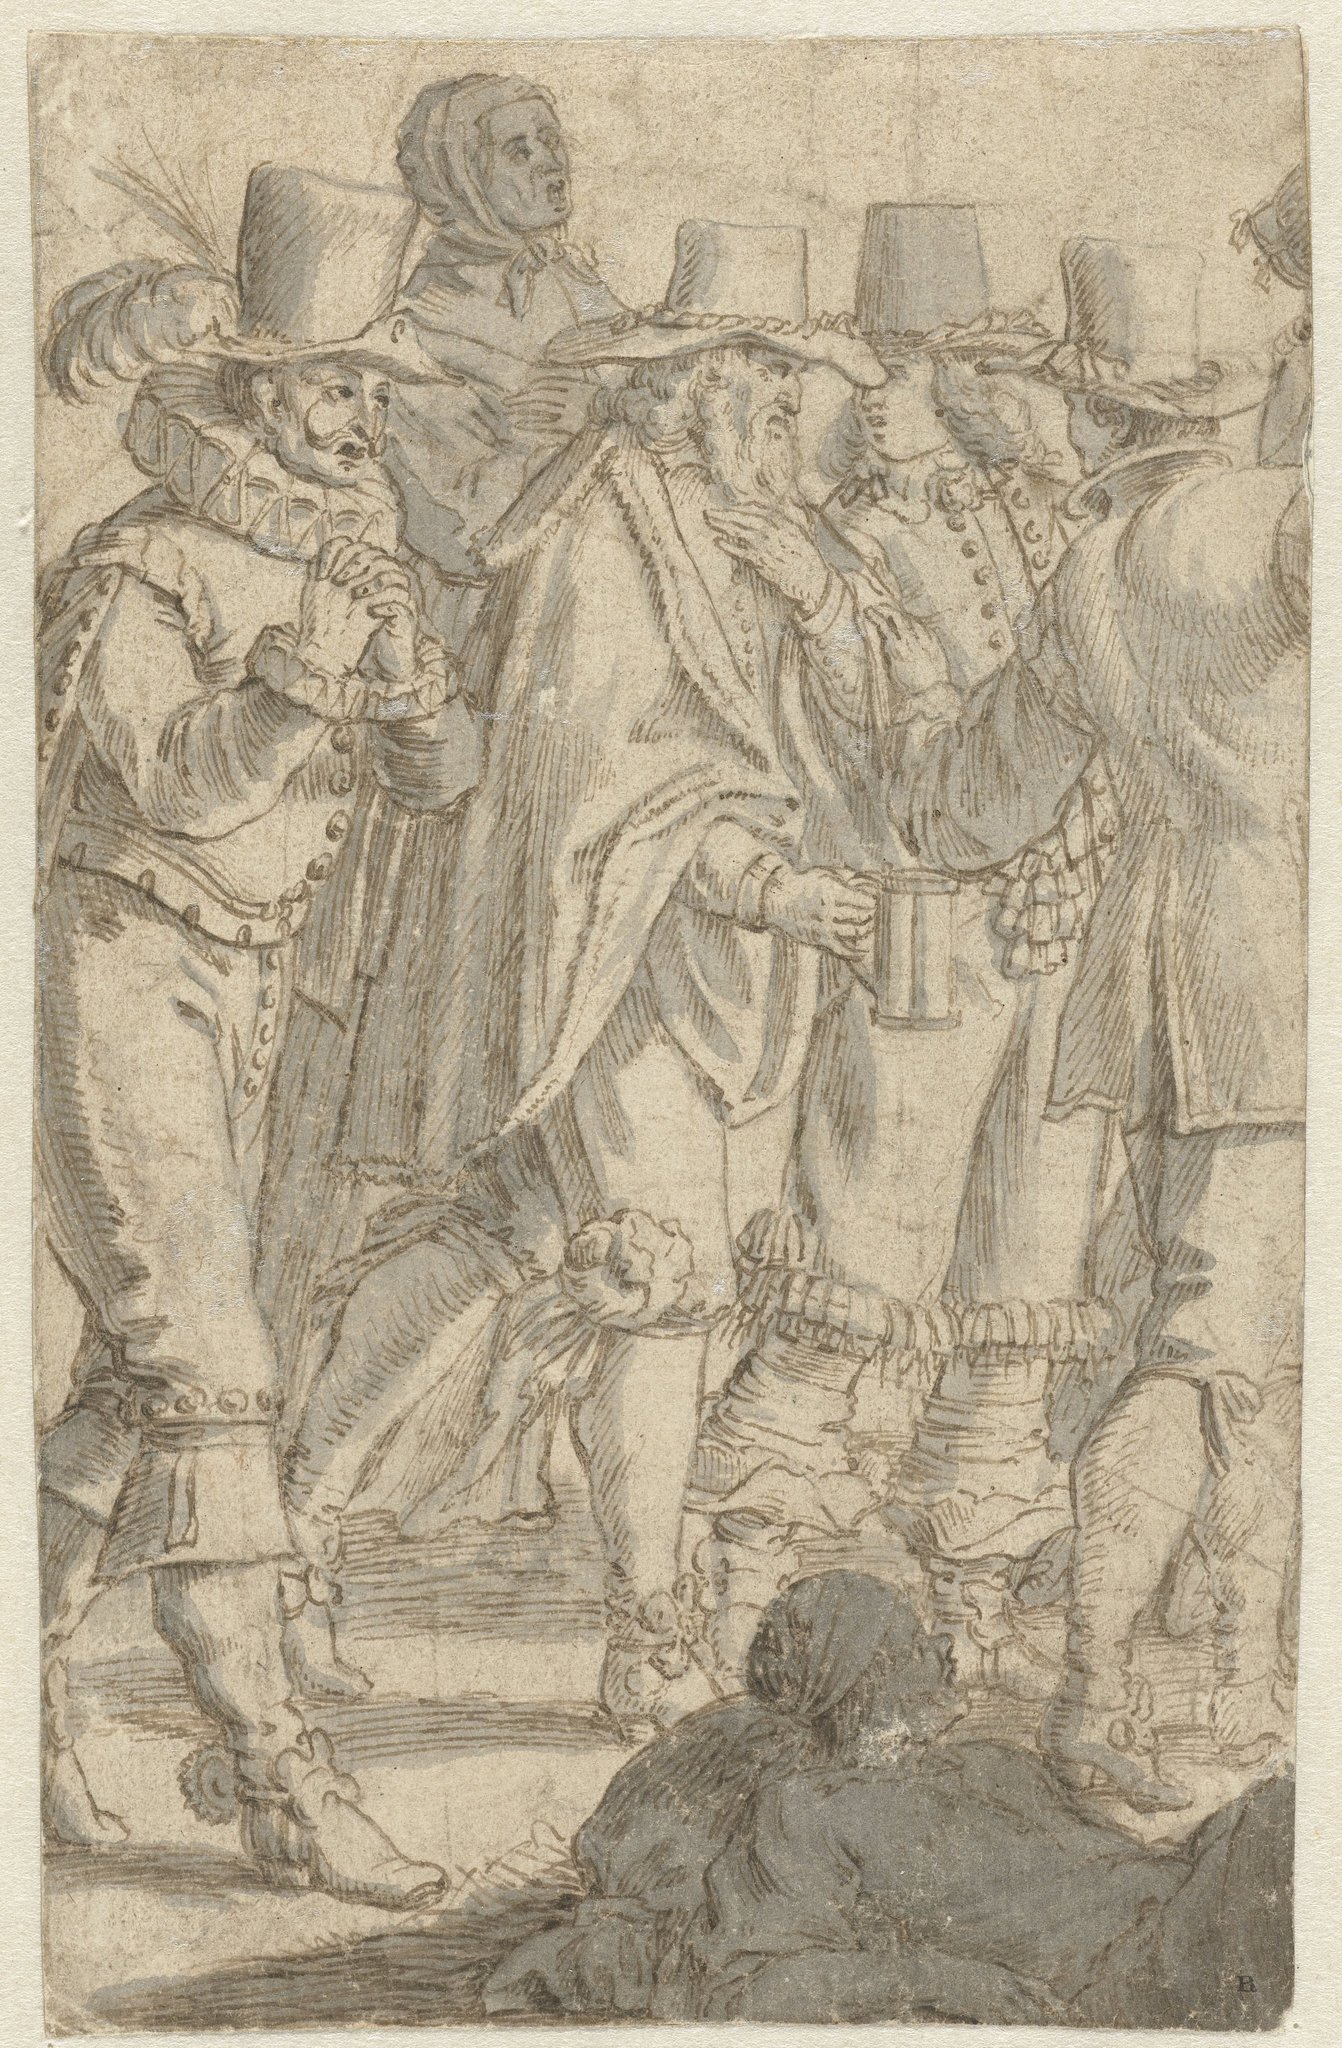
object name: drawing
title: Uittocht van het Spaanse garnizoen uit Breda (1637)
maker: Anonymous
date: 1637-1700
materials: ink, paper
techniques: brush, pen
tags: retreat of the defeated, historical events and situations